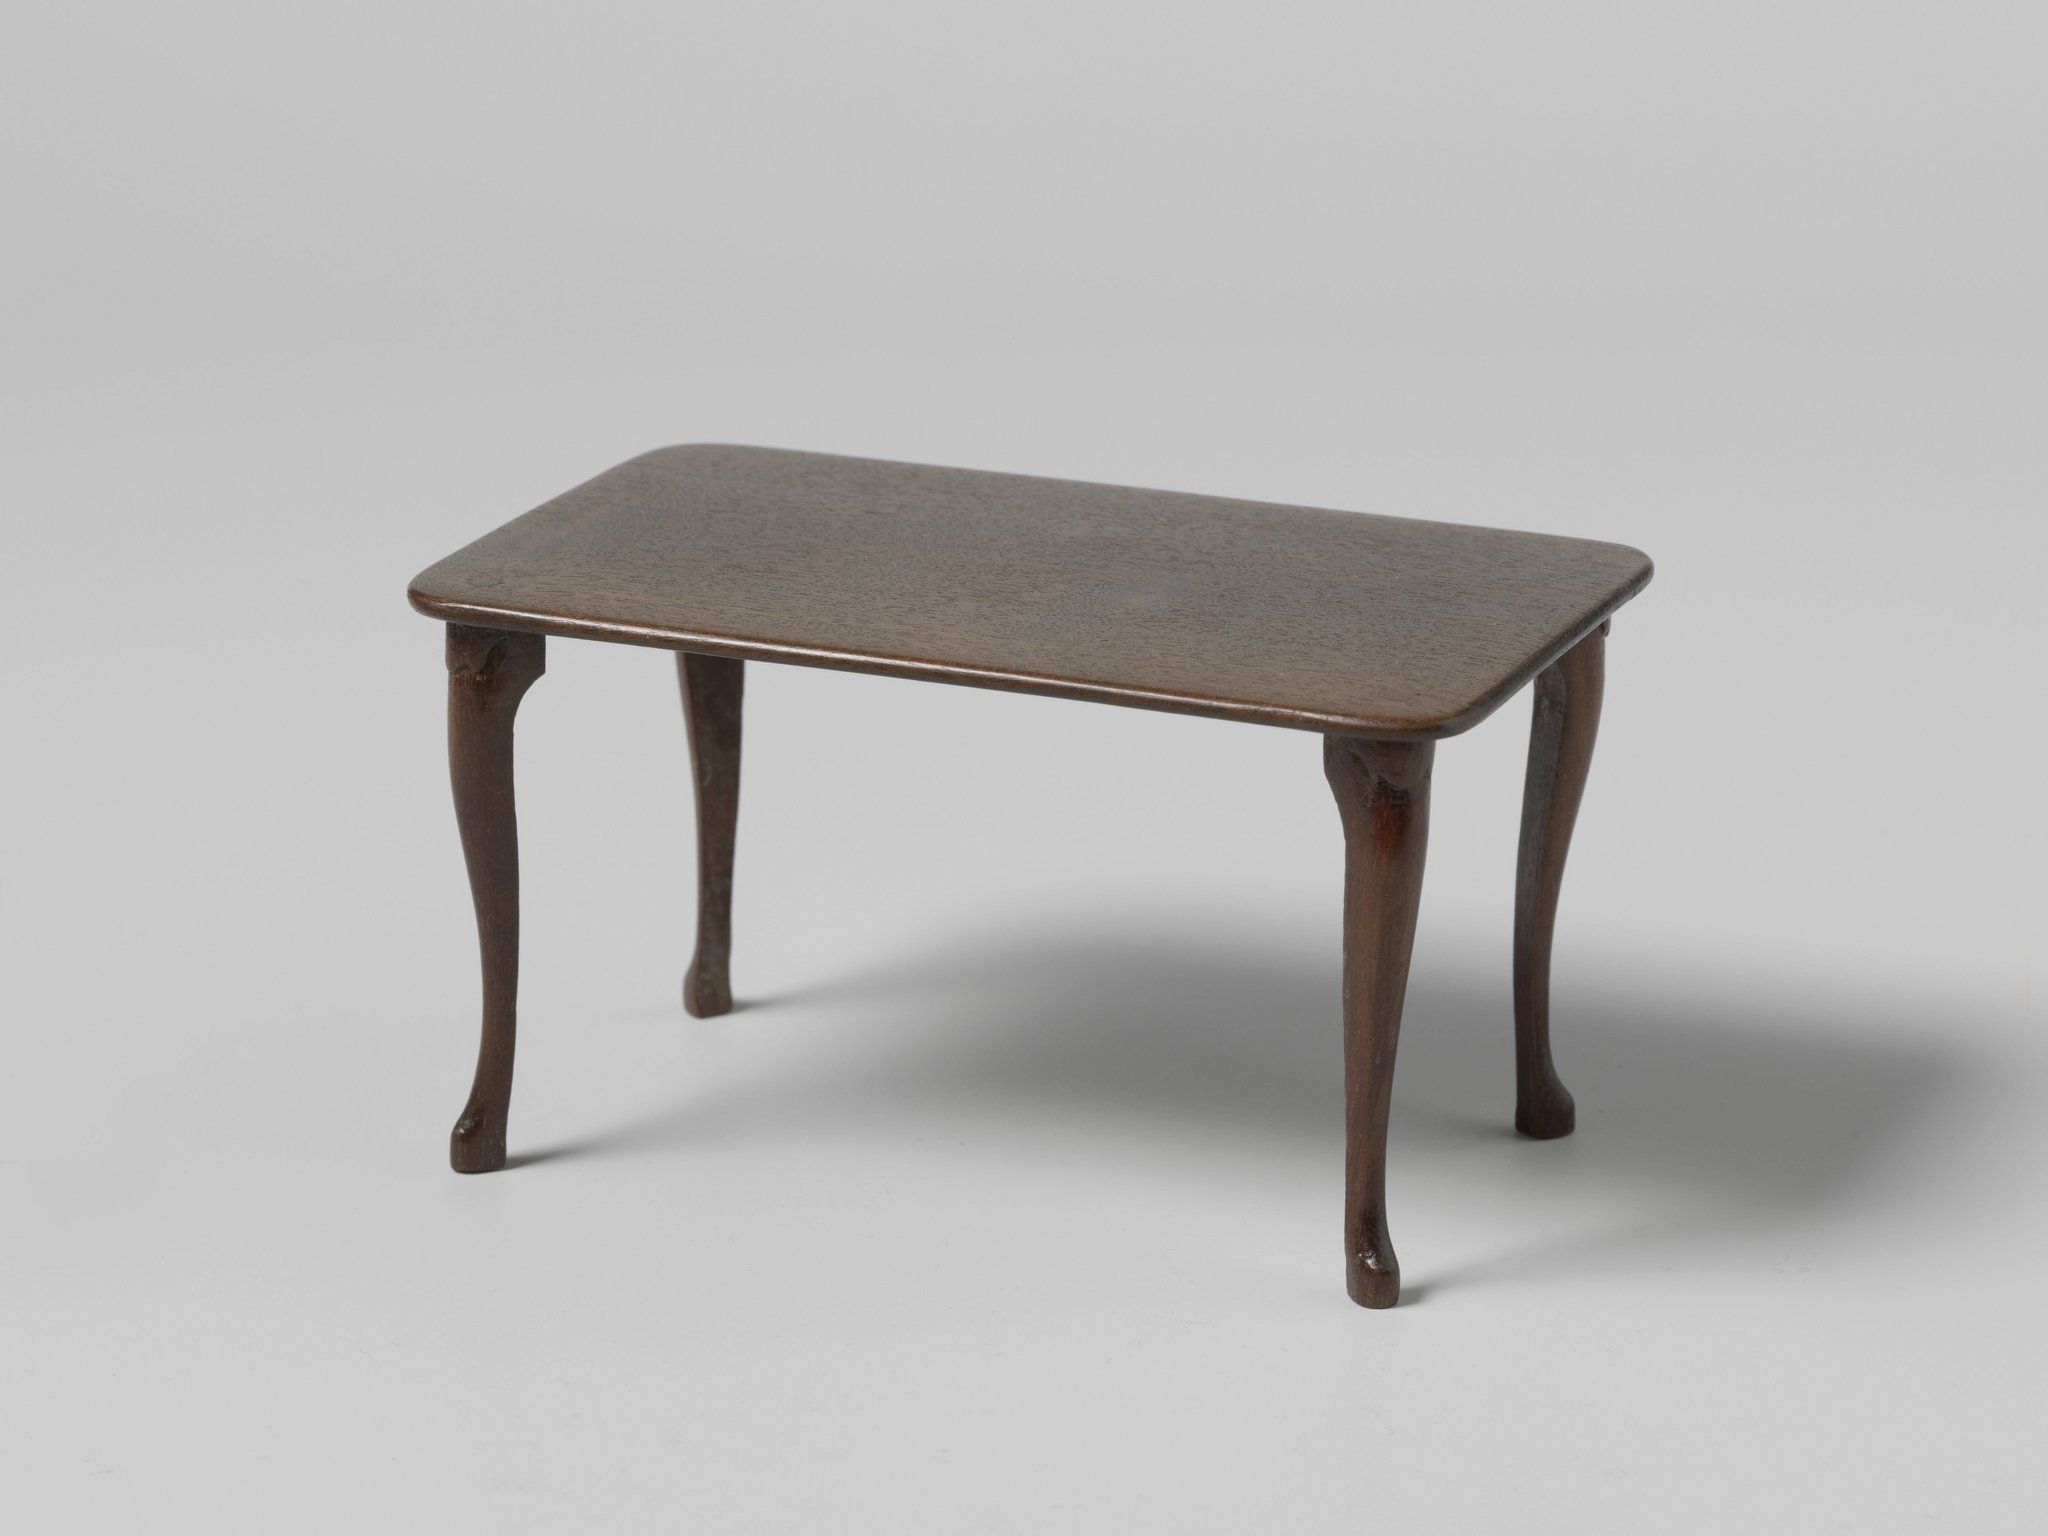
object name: miniature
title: Tafel met rechthoekig blad op vier s-vormige poten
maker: Anonymous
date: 1750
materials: wood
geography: amsterdam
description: Tafel van mahoniehout, met rechthoekig blad met afgeronde hoeken, op vier s-vormige poten